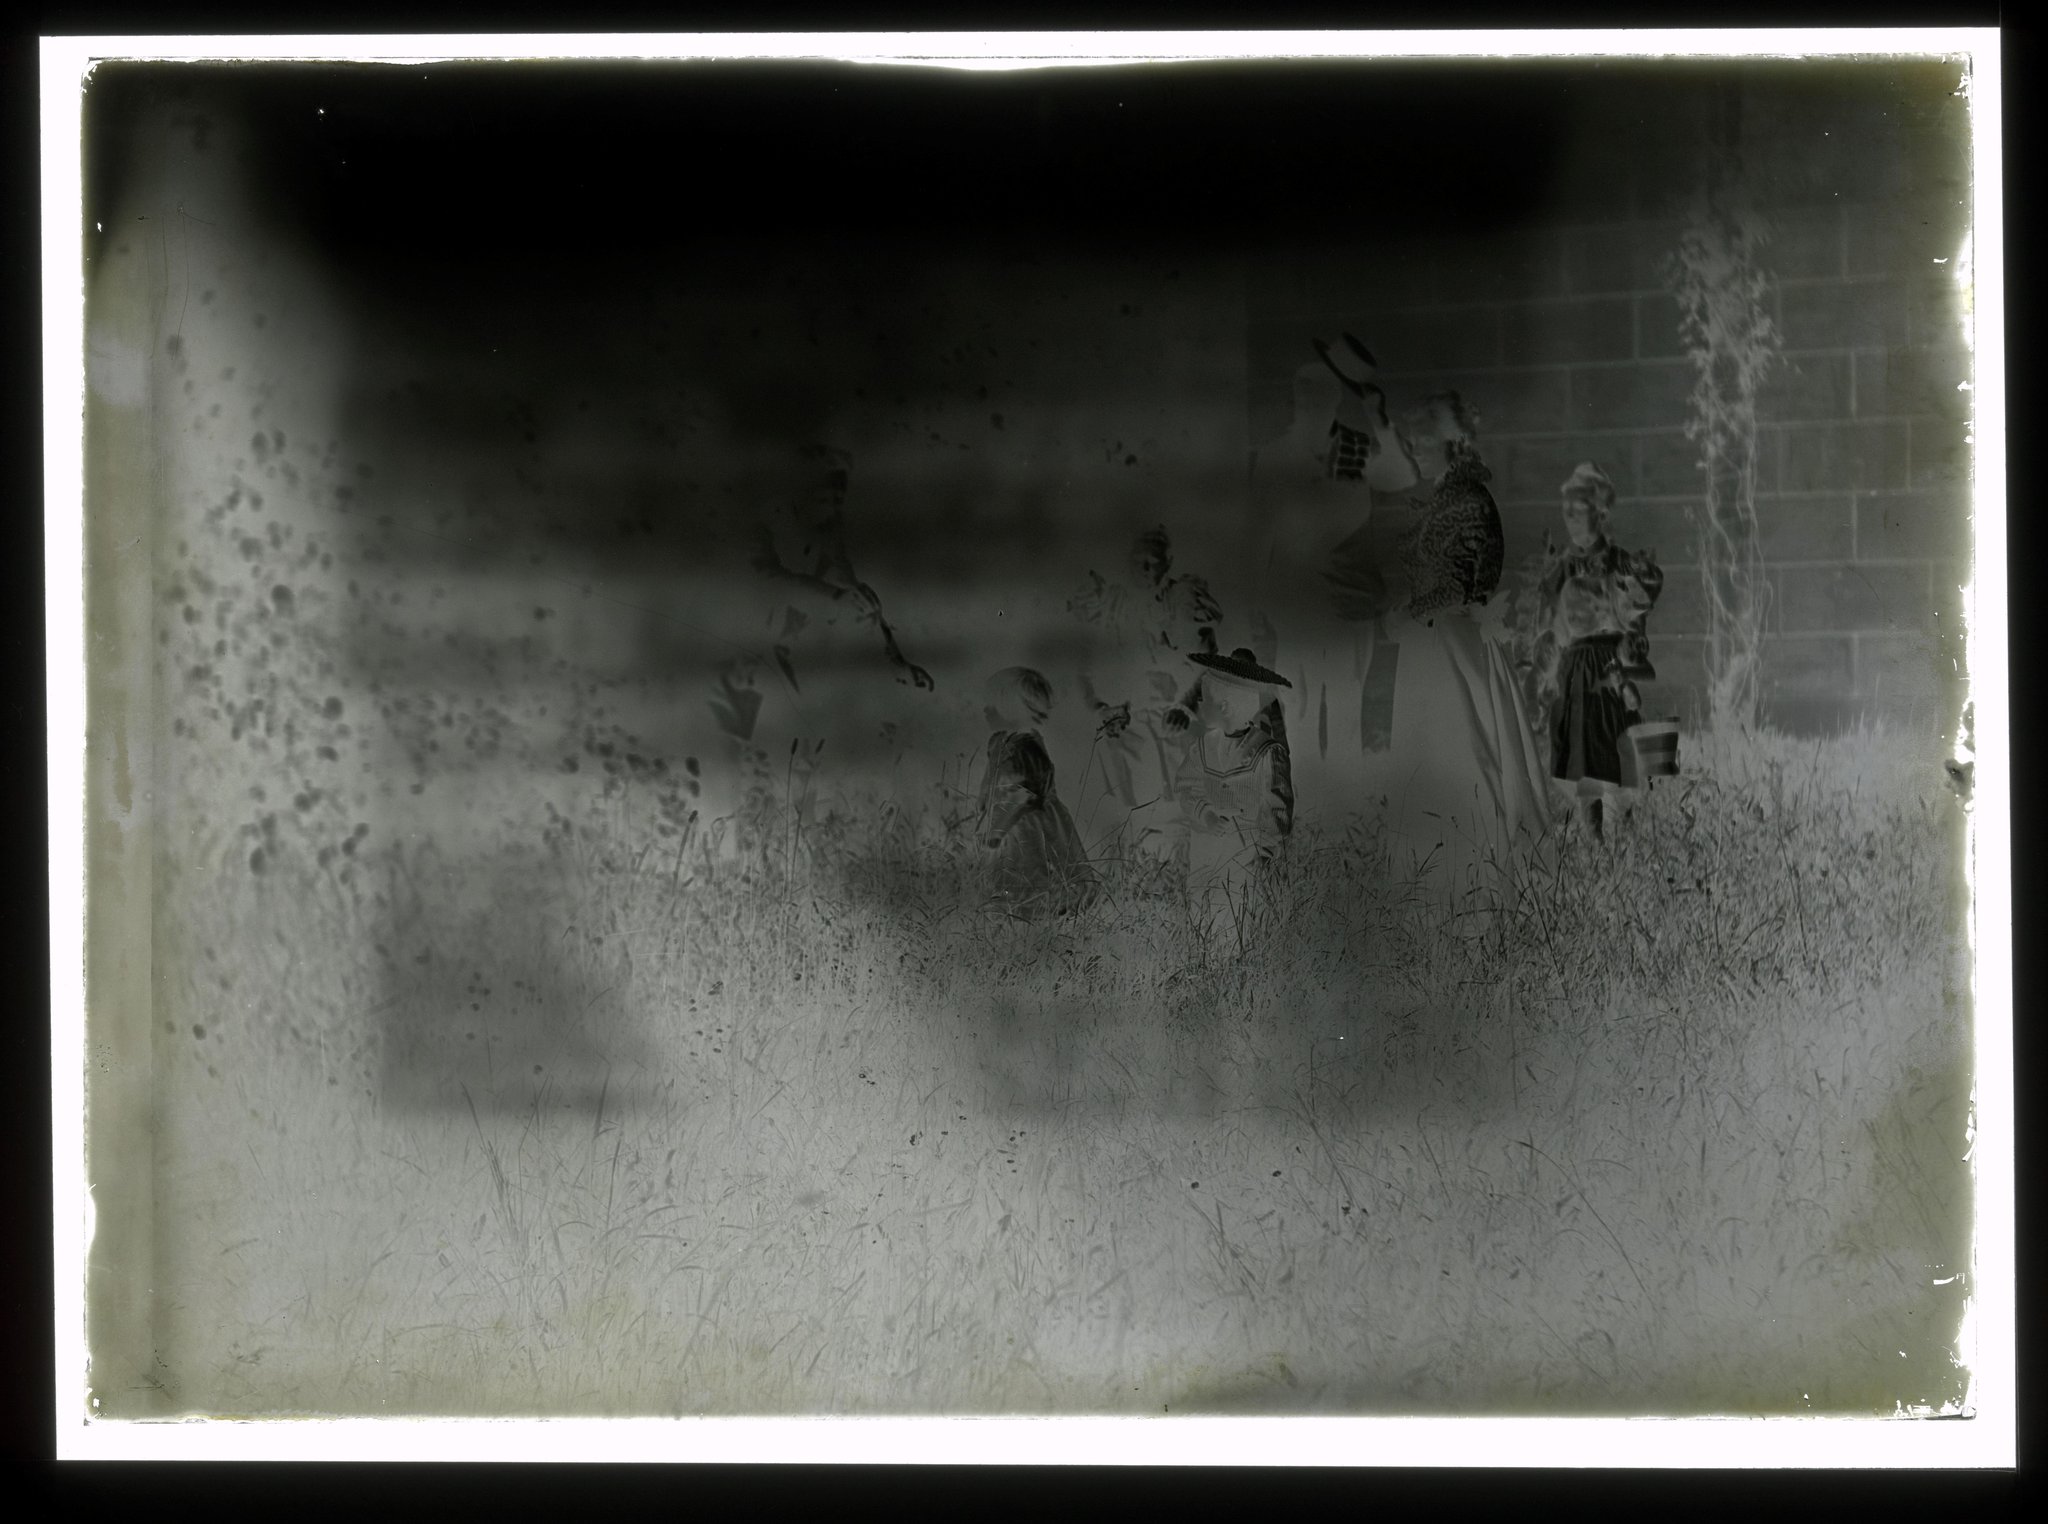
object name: glasnegatief, glasplaatnegatief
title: Groep mensen op een grasveld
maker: laurens lodewijk kleijn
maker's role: draughtsman, painter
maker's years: 1826-1909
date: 1865-1900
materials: glass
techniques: collodion process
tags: anonymous historical persons portrayed in a group, in a group-portrait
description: Onderdeel van een groep glasnegatieven uit de nalatenschap van de schilder Laurens Lodewijk Kleijn, met stillevens, portretten, zelfportretten en kunstreproducties.